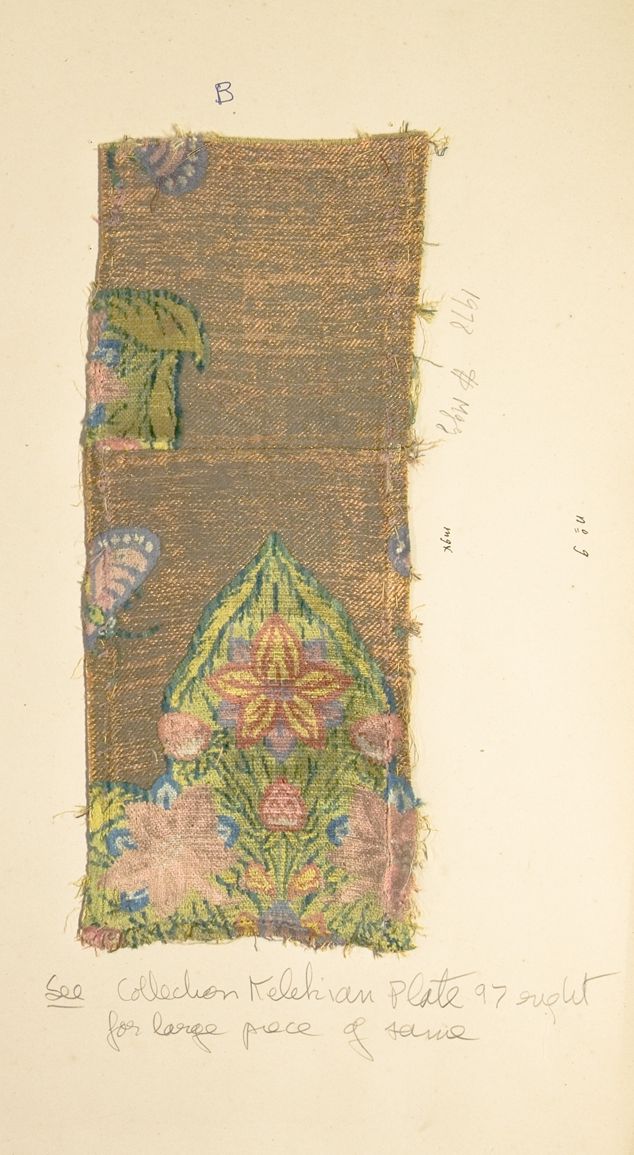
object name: textile fragment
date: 1601-1700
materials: metal thread, silk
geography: india